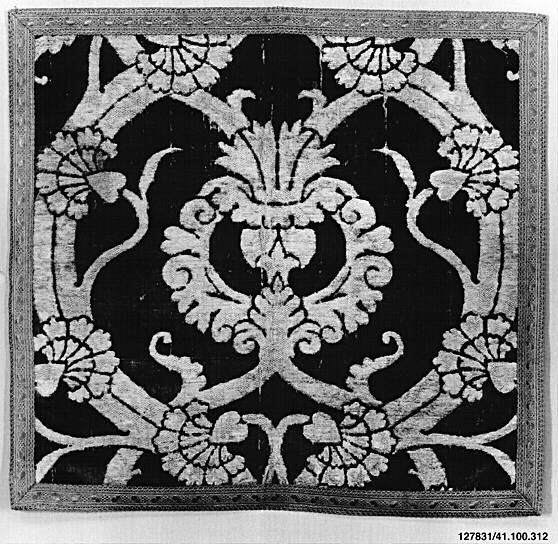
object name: panel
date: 1501-1600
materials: metal thread, silk, silver, silver gilt, thread, velvet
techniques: brocade, cutting, voiding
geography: turkey